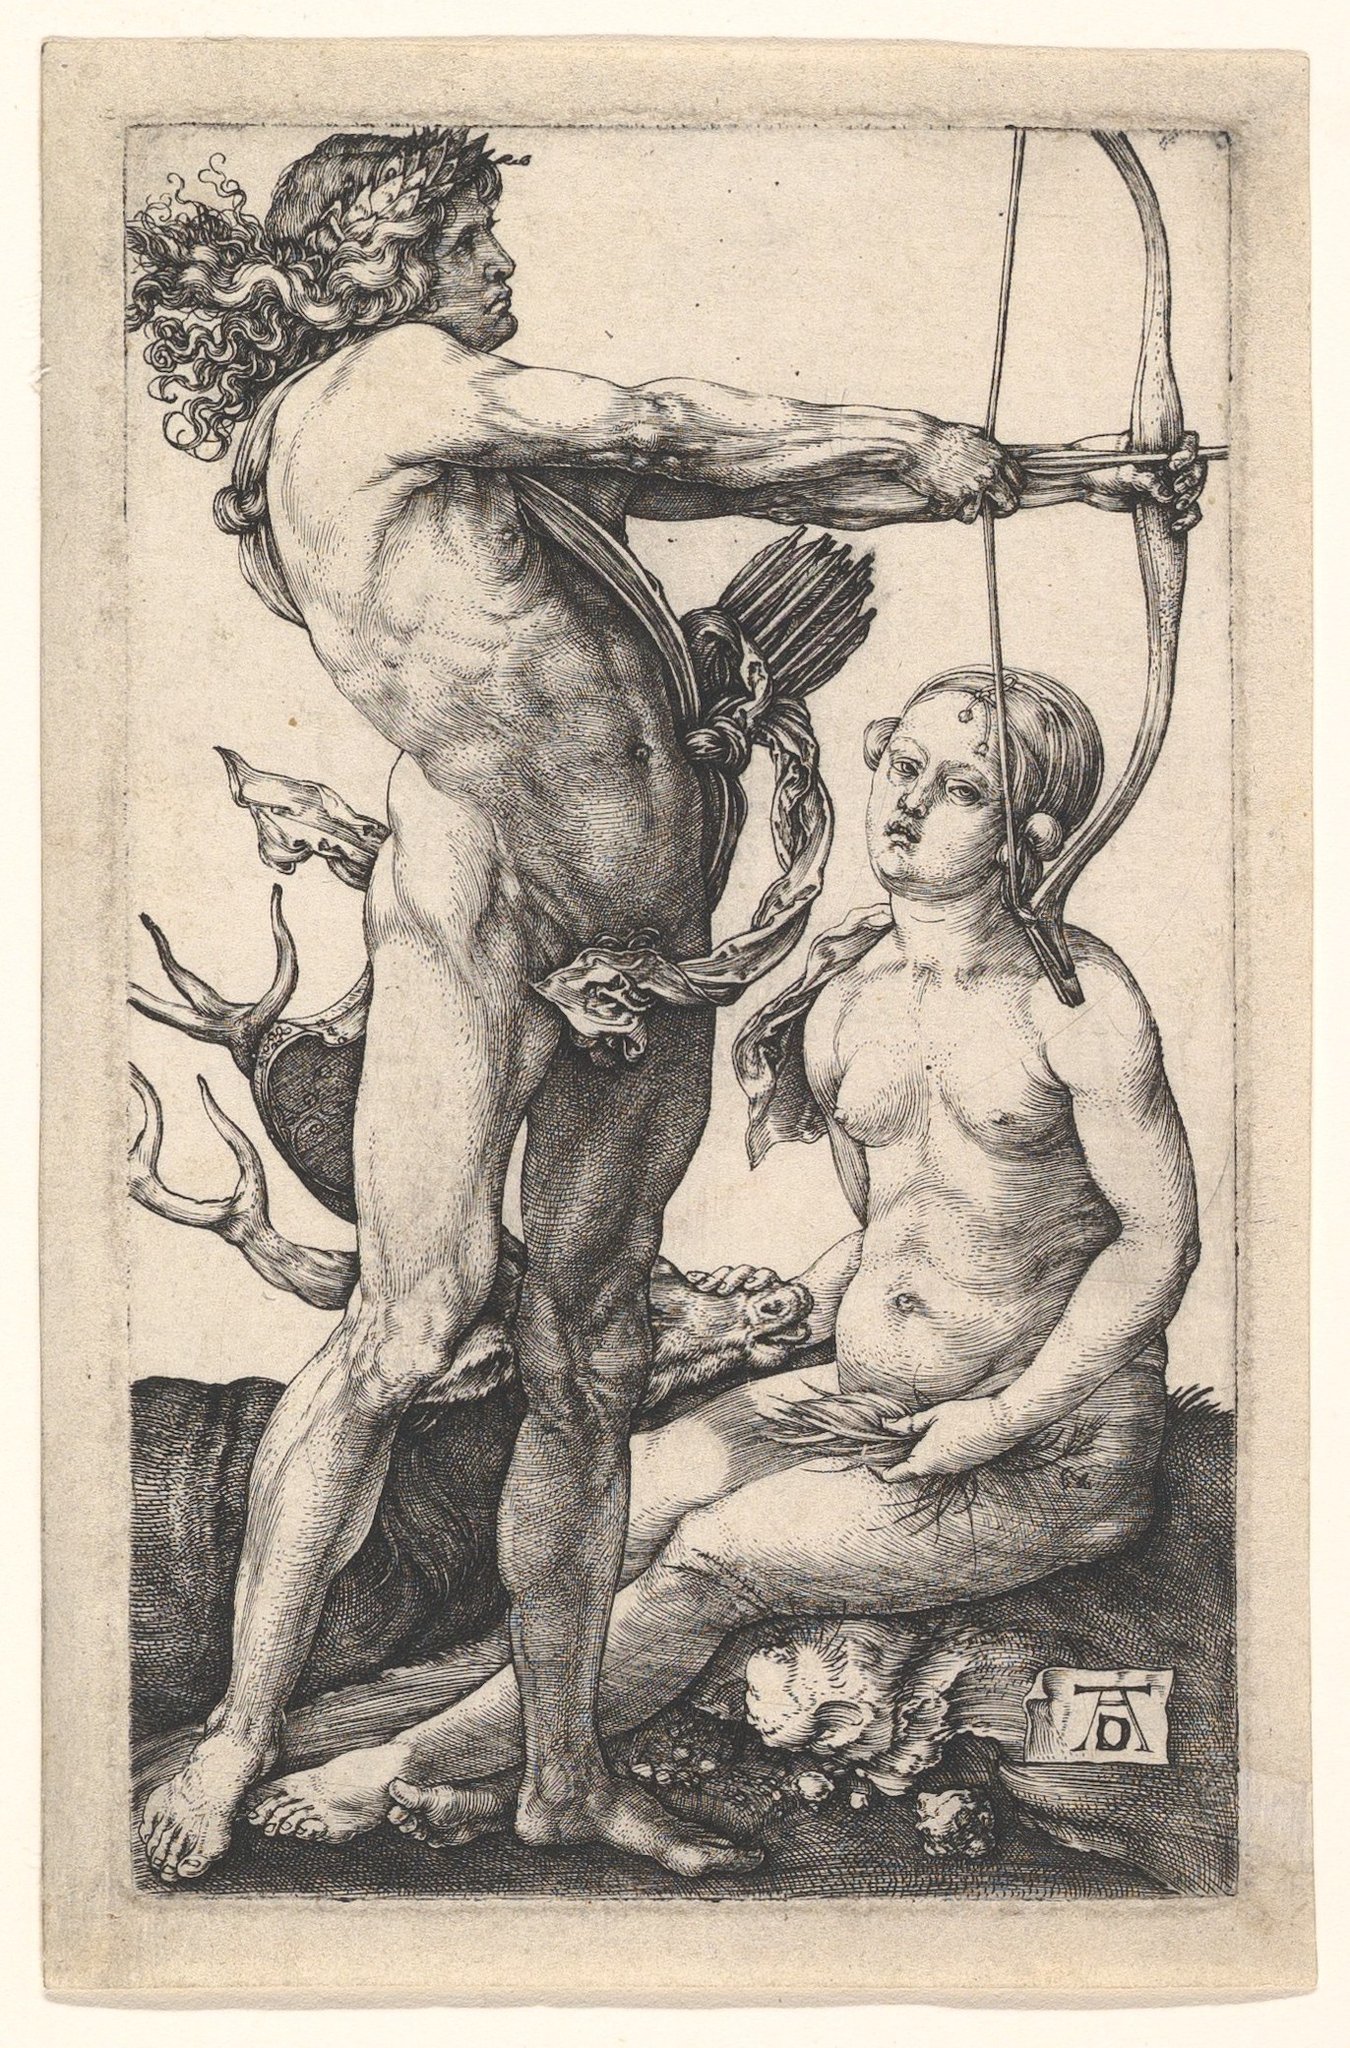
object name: print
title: Apollo and Diana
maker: albrecht dürer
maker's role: artist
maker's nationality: german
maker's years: 1471-1528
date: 1503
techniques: engraving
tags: bow and arrow,apollo,diana